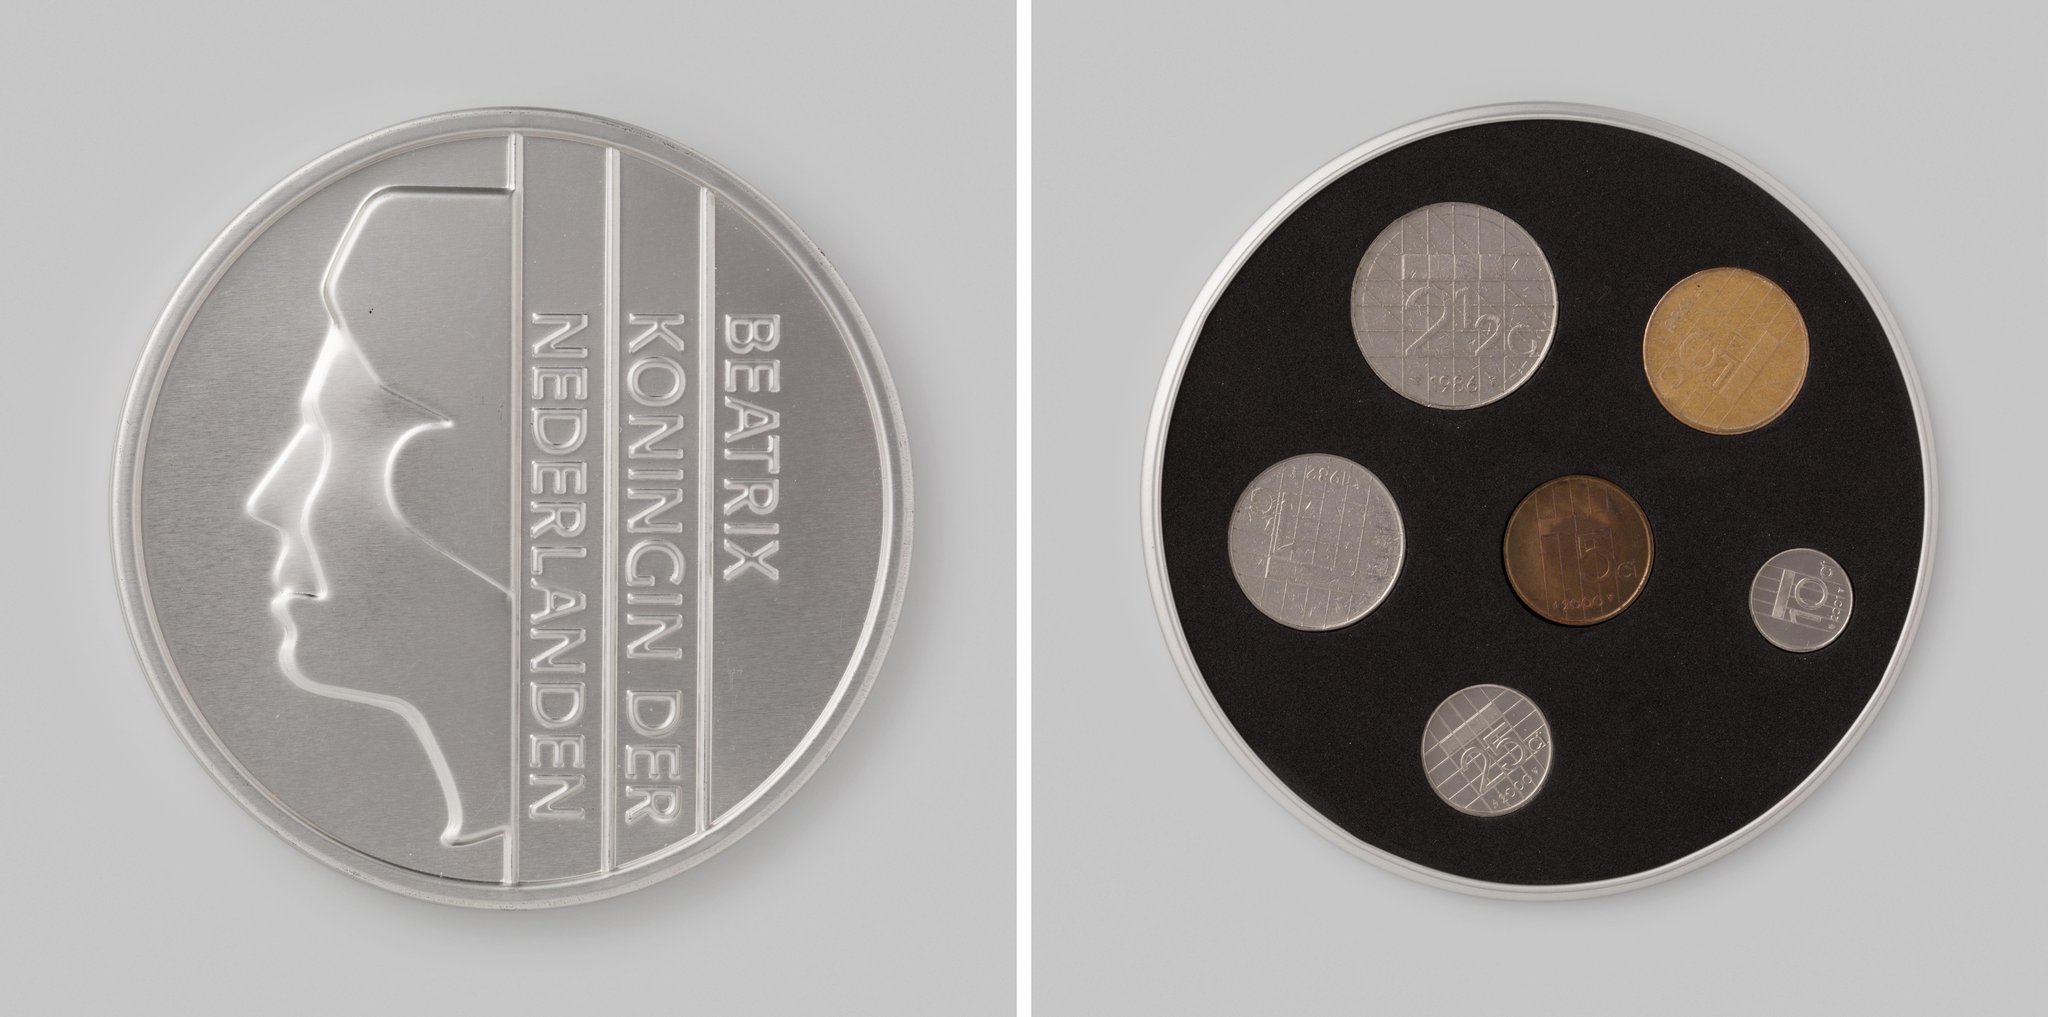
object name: coin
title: Een herinnering aan de Nederlandse gulden...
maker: bruno ninaber van eyben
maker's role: designer, jeweler, sculptor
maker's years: 1950-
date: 1982-2002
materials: bronze, nickel, paper, metal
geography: netherlands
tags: beatrix (koningin der nederlanden), netherlands, europe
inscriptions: inscription: ‘Een herinnering aan de Nederlandse gulden.... Tot januari 2002 was de gulden onze nationale munteenheid. De gulden is ontstaan in de 14e eeuw, waarmee deze munteenheid een belangrijk deel uitmaakt van onze rijke vaderlandse geschiedenis. Voor vele generaties Nederlanders waren de guldenmunten een vertrouwd beeld in het dagelijkse leven, bijvoorbeeld ten tijde van de tachtigjarige oorlog (1568-1648), de glorietijd van de V.O.C. en de turbulente jaren van de Tweede Wereldoorlog. De guldenmunten zijn daarmee een tastbaar stukje geschiedenis om te koesteren en om door te geven aan toekomstige generaties Nederlanders.....’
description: Rond blikken doosje, gemaakt als een gulden uit 2001, waarin 6 Nederlandse munten: een vijfje (1988), een rijksdaalder (1986), een gulden (1982), een kwartje (2000), een dubbeltje (2001) en een stuiver (2000). Doosje heeft een los deksel, waarin een papiertje met opschrift. Gemaakt naar aanleiding van de overgang van gulden naar Euro.